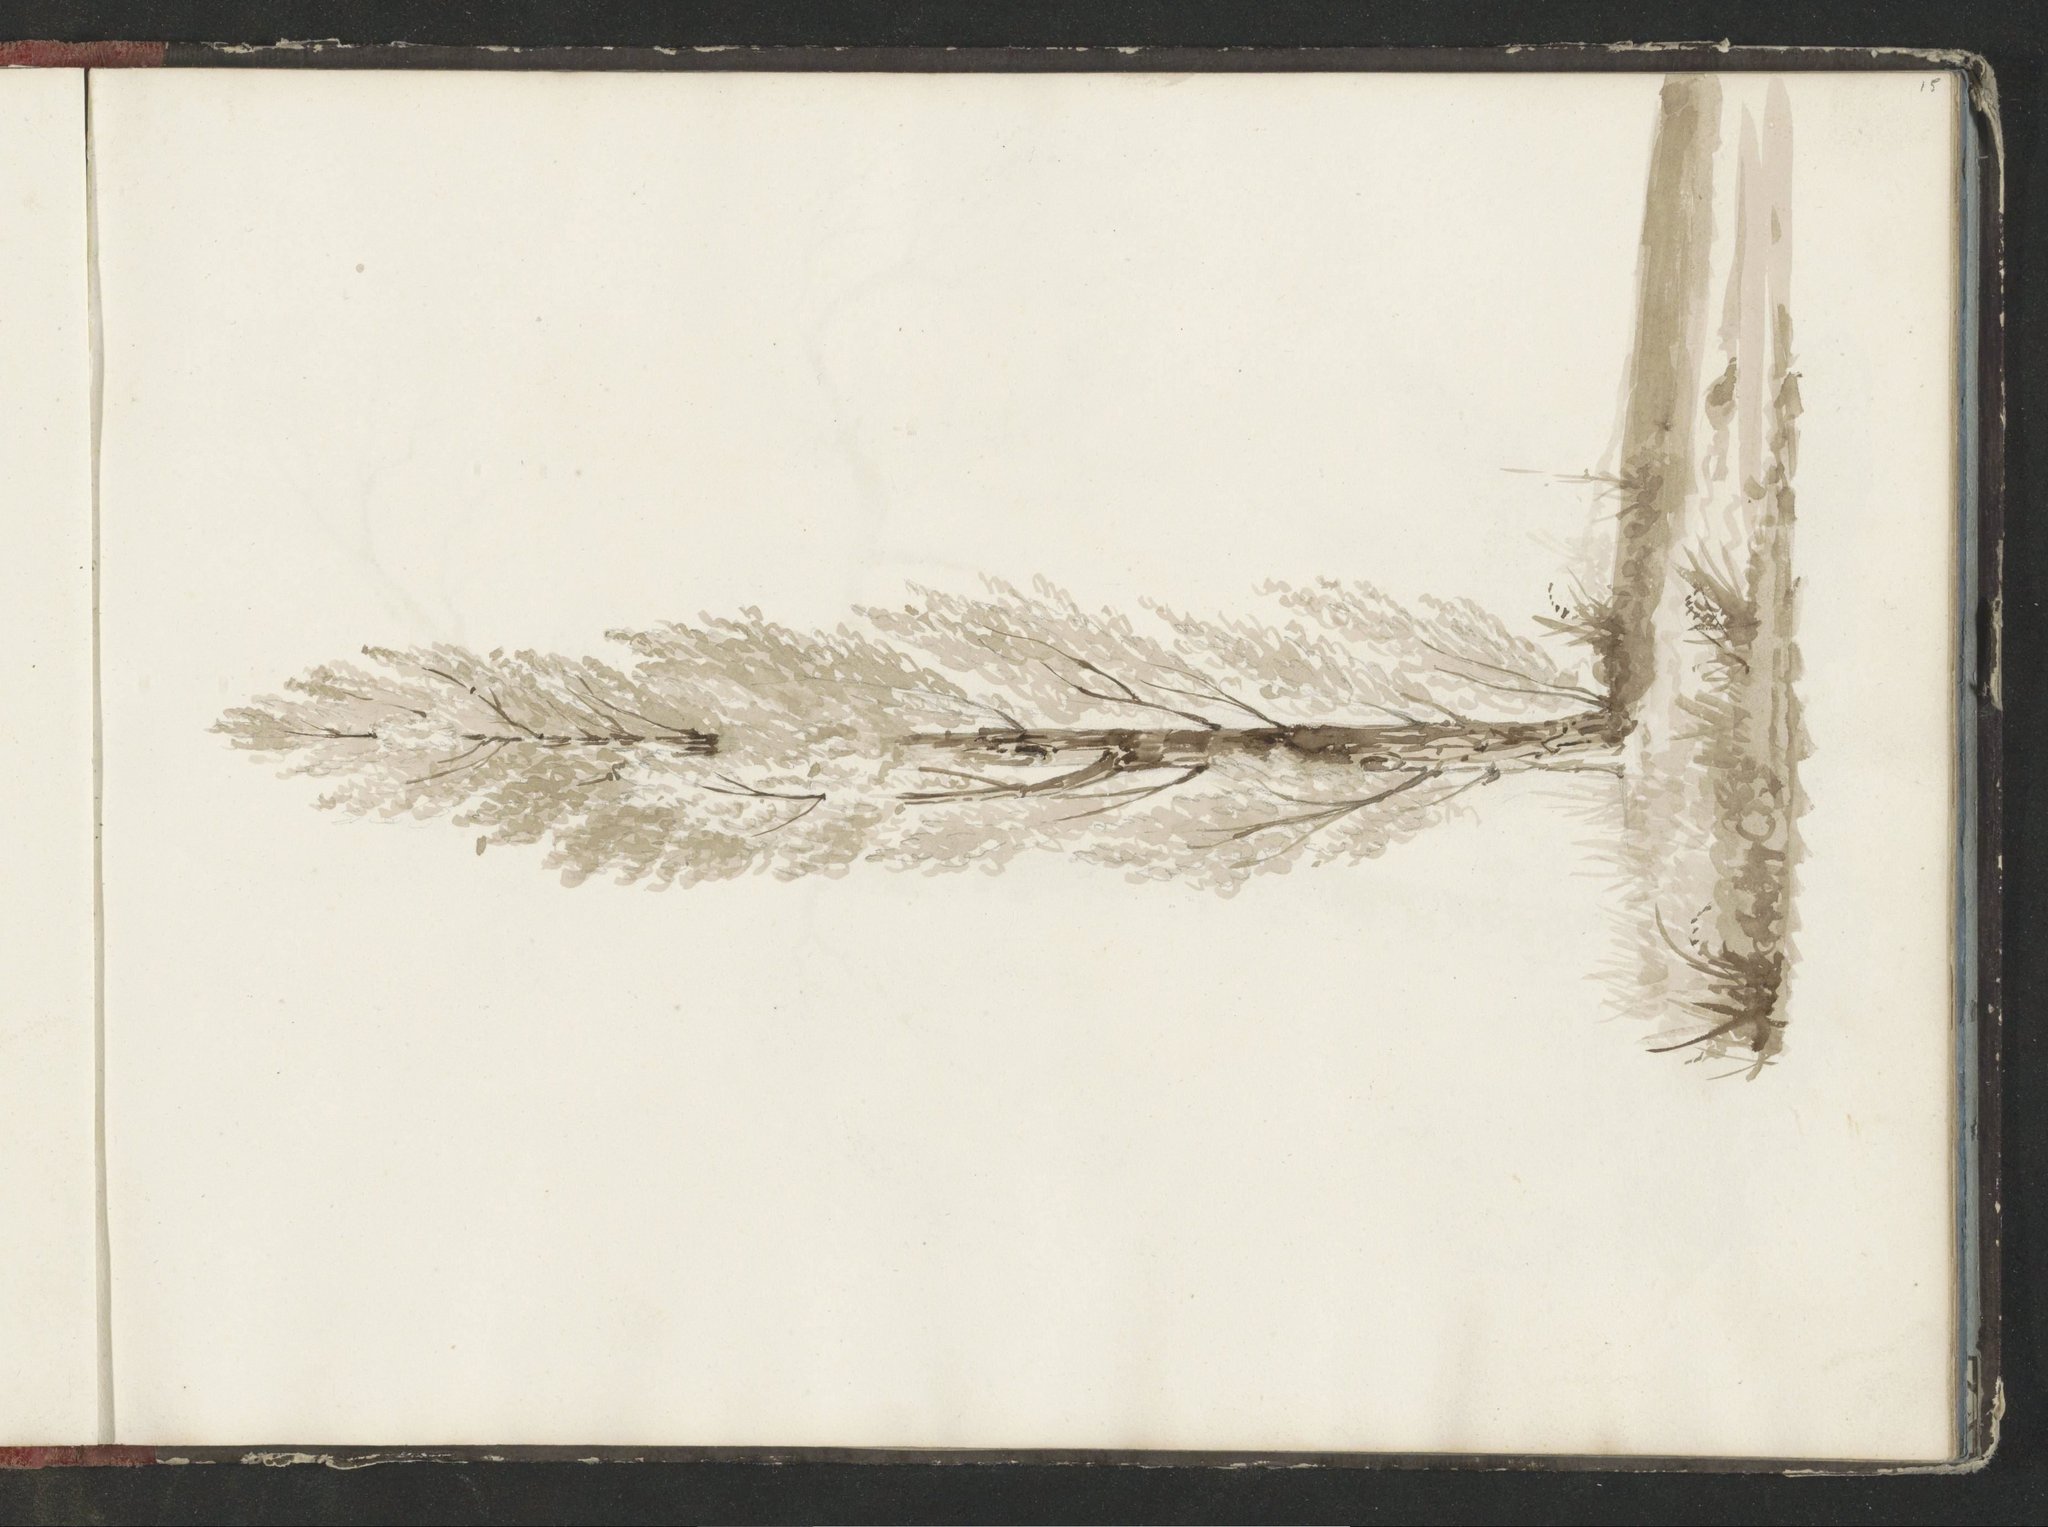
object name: sketchbook leaf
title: Landschap met een boom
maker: Anonymous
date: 1819-1870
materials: ink, paper, pencil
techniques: brush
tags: trees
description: Blad 15 recto uit een schetsboek met 39 bladen.